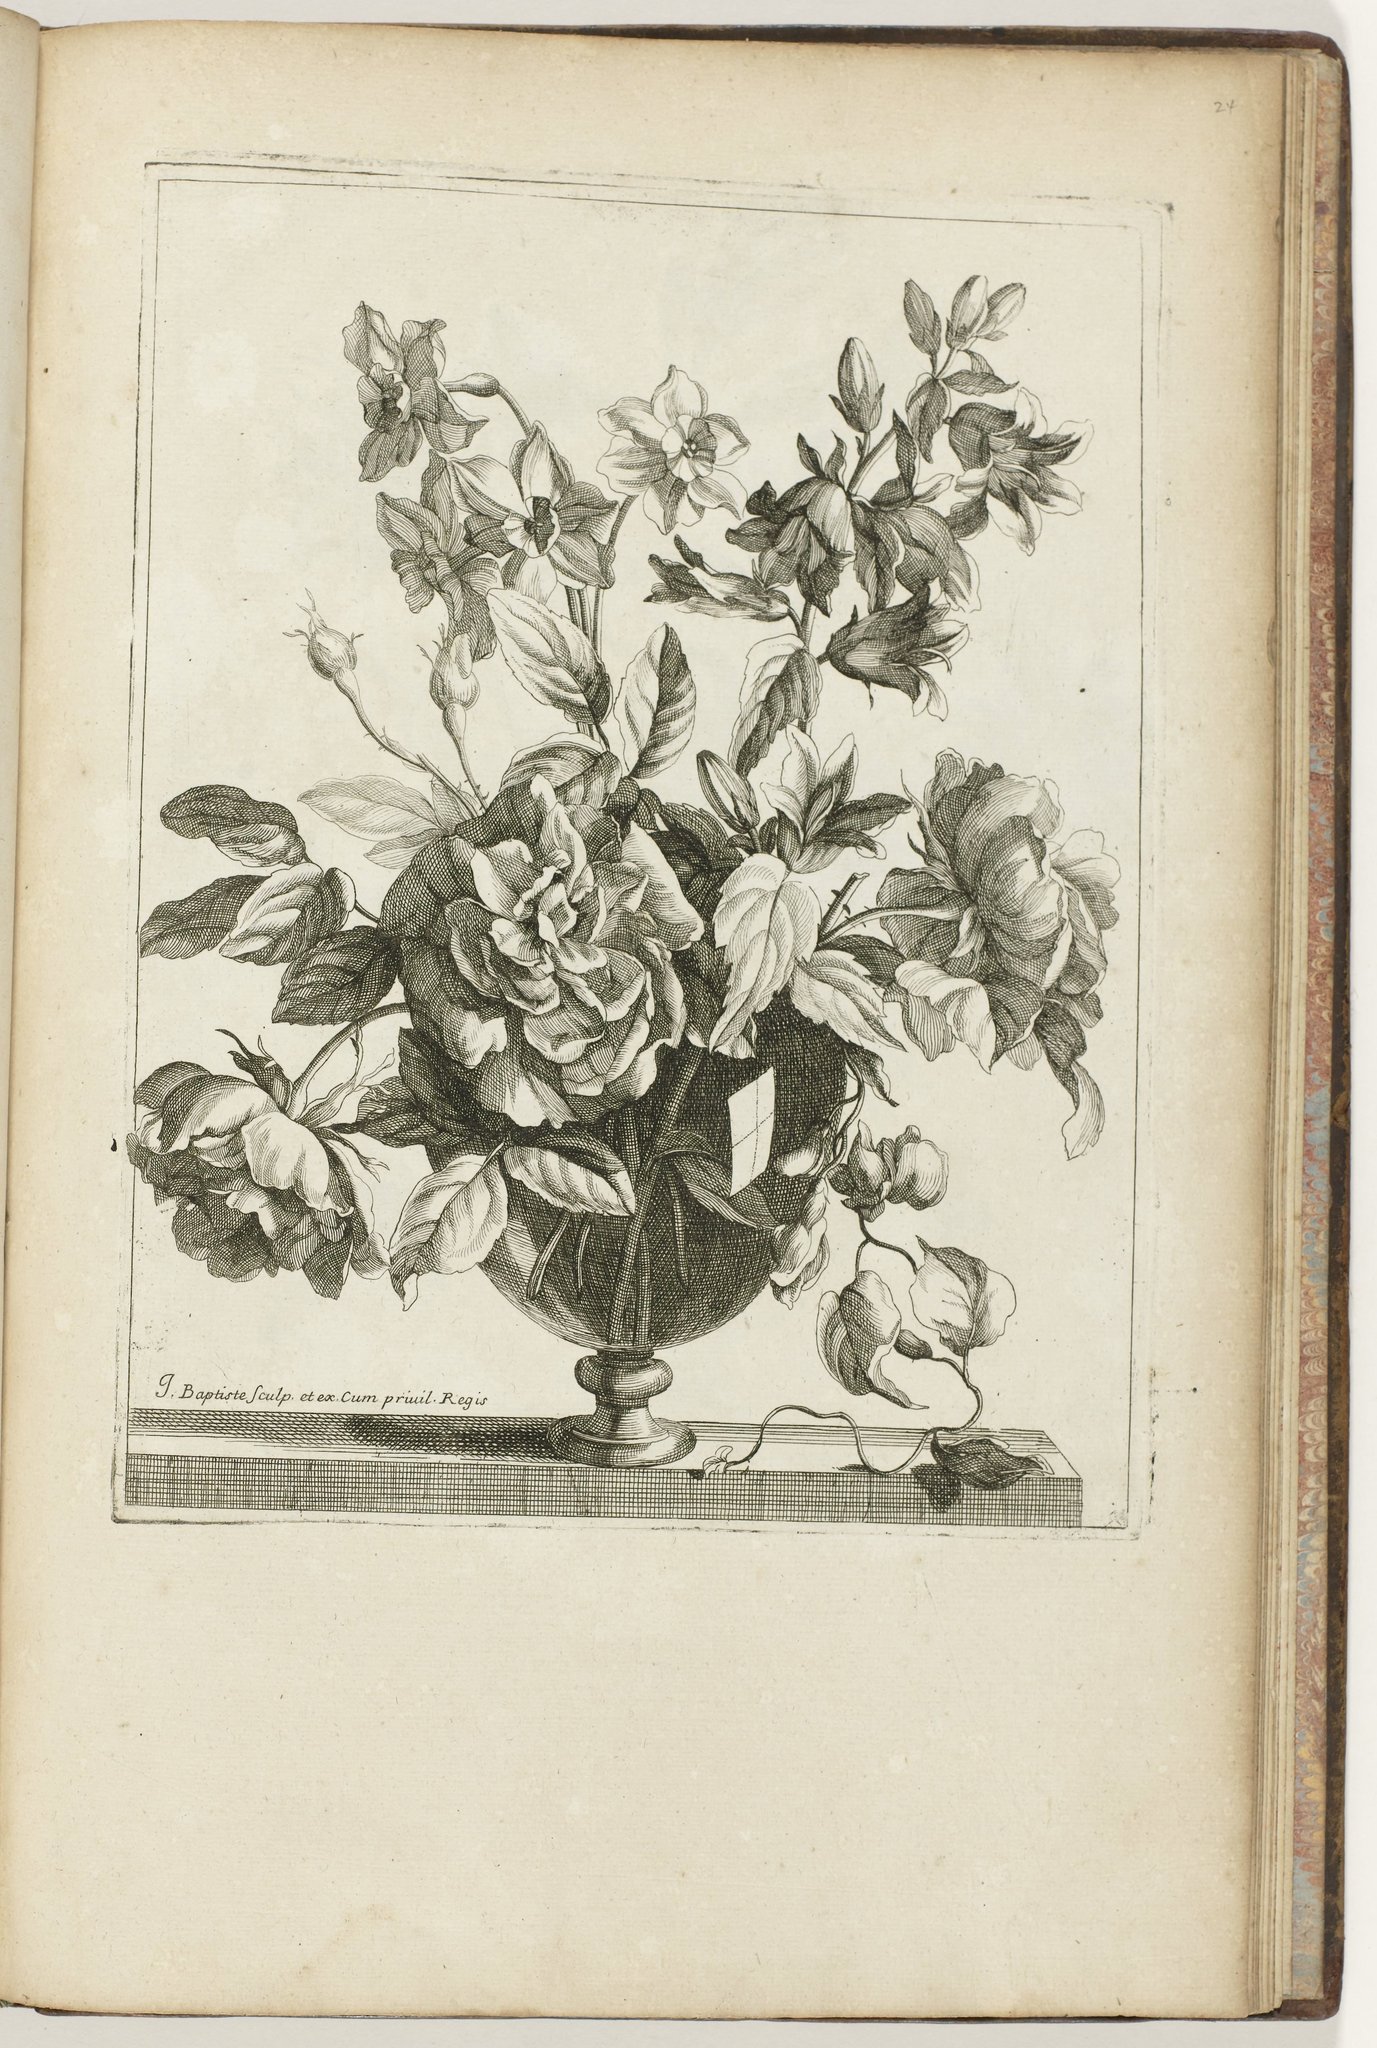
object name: print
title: Boeket in glazen vaas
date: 1680-1695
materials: paper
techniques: etching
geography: paris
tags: flowers in a vase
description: Boeket in glazen vaas. Prent maakt deel uit van een album.